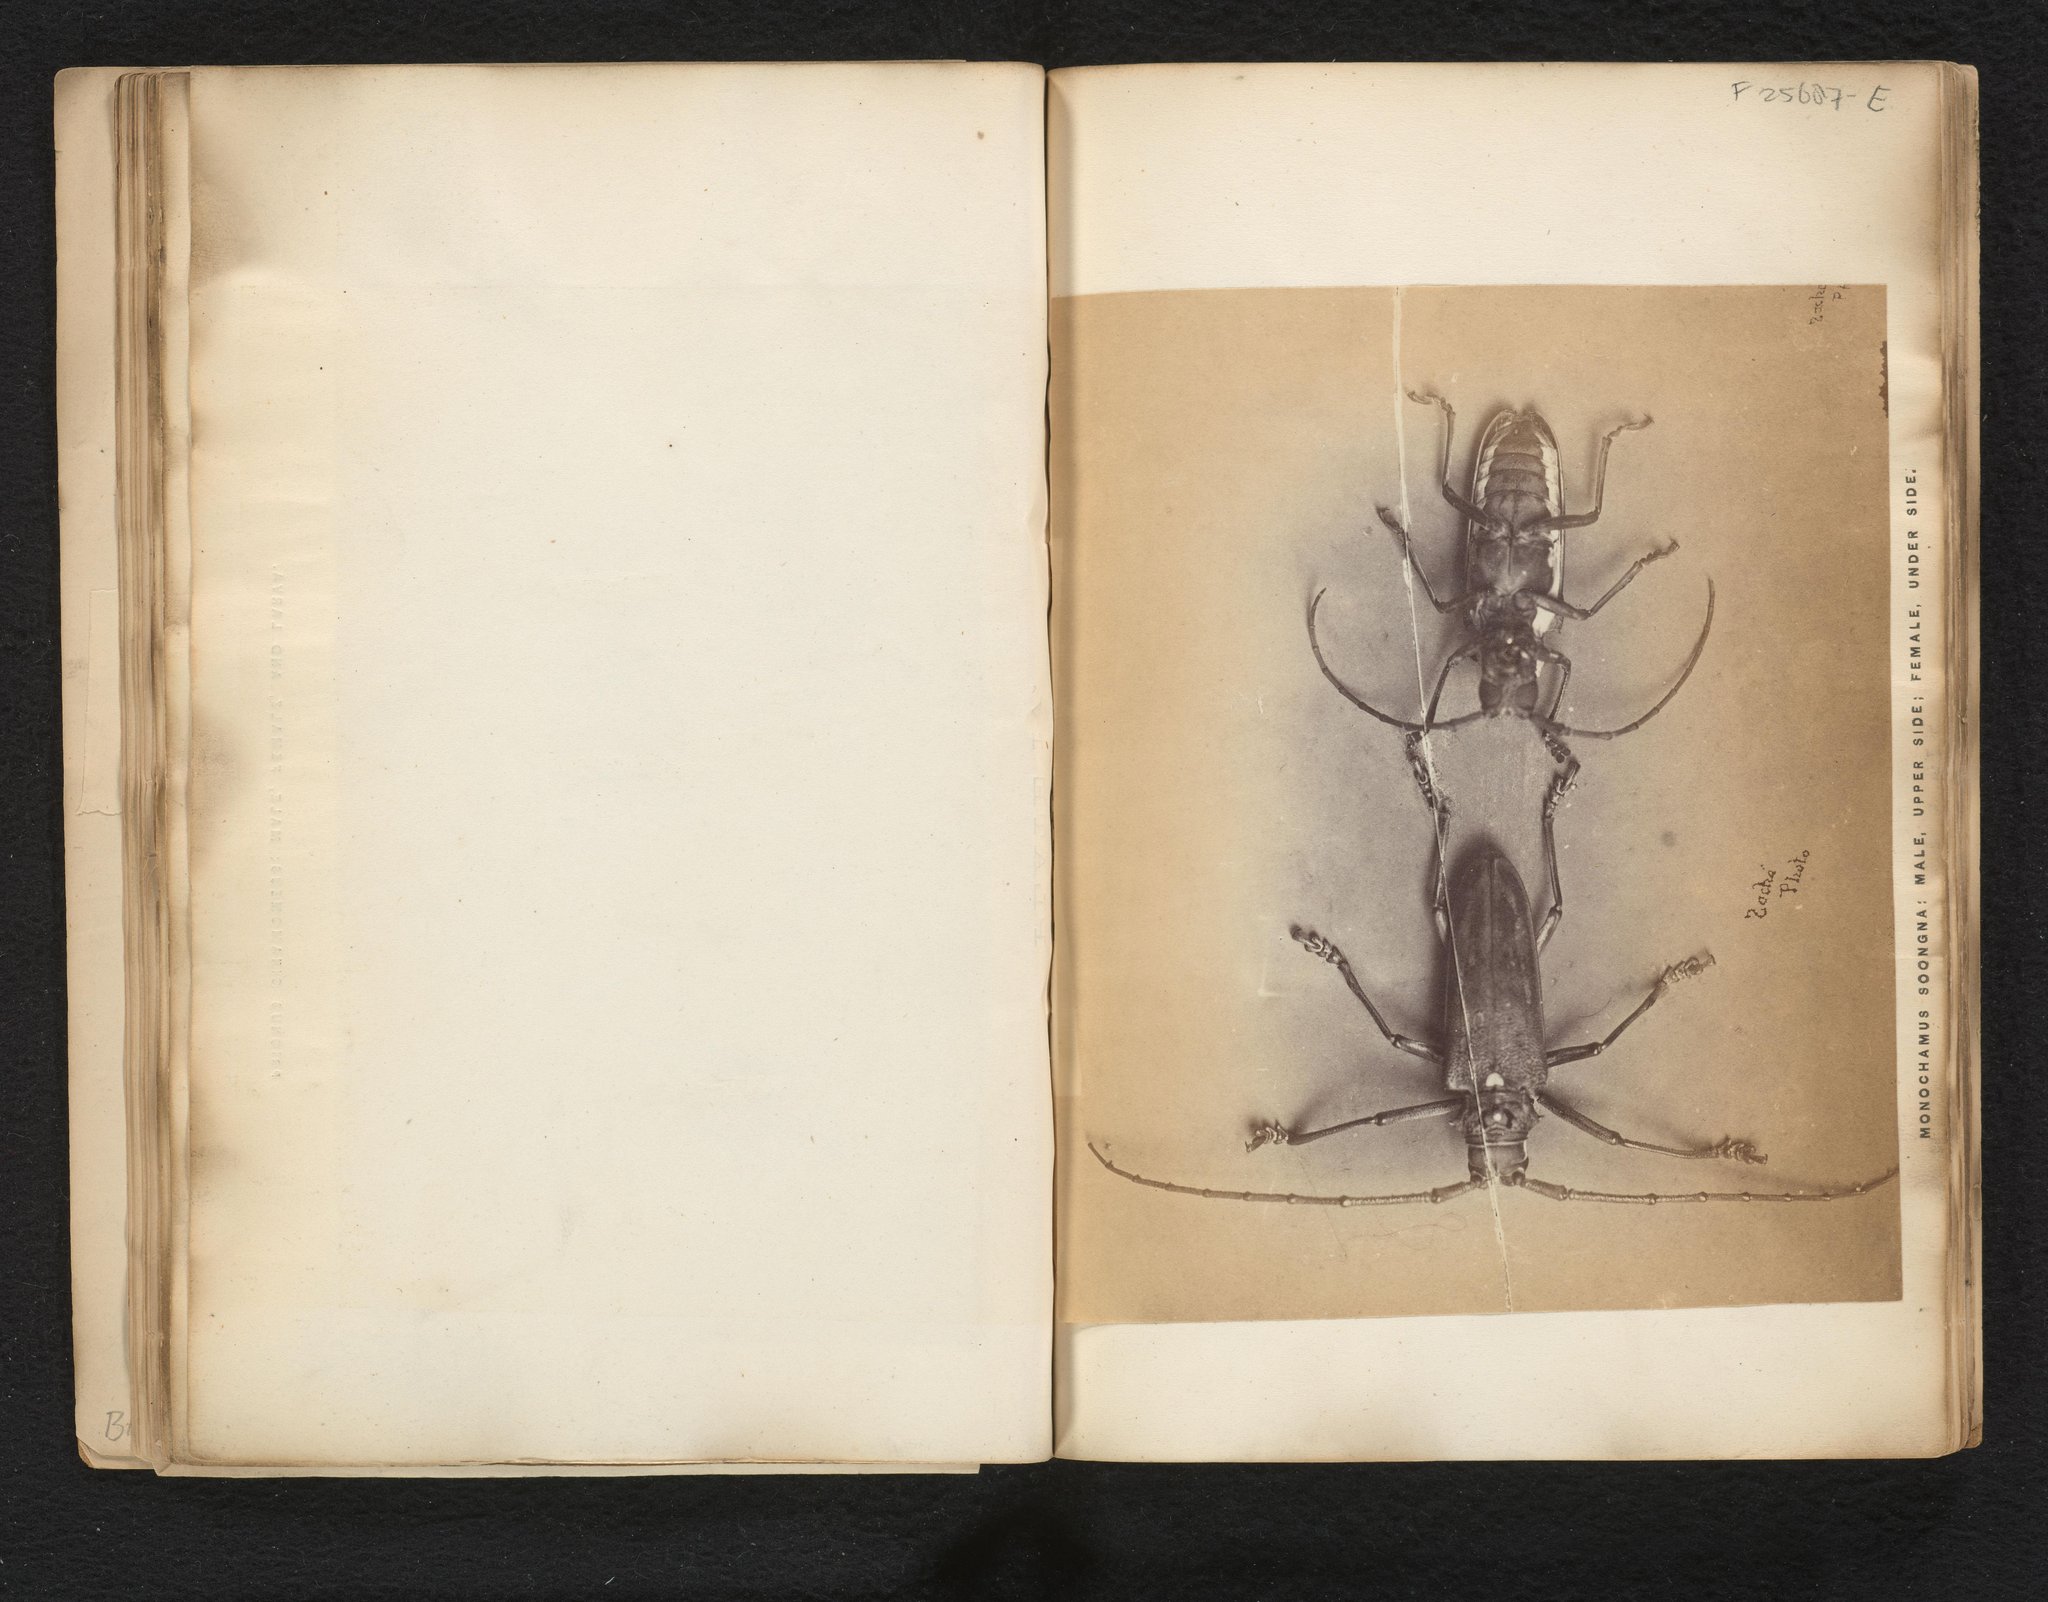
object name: page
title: Two longhorn beetles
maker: john edward saché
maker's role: fotograaf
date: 1863-1868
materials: paper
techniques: albumen print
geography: india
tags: insects: beetle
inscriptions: inscription: ‘Saché Photo’, inscription: ‘PLATE V.’, inscription: ‘MONOCHAMUS SOONGNA: MALE, UPPER SIDE; FEMALE, UNDER SIDE.’